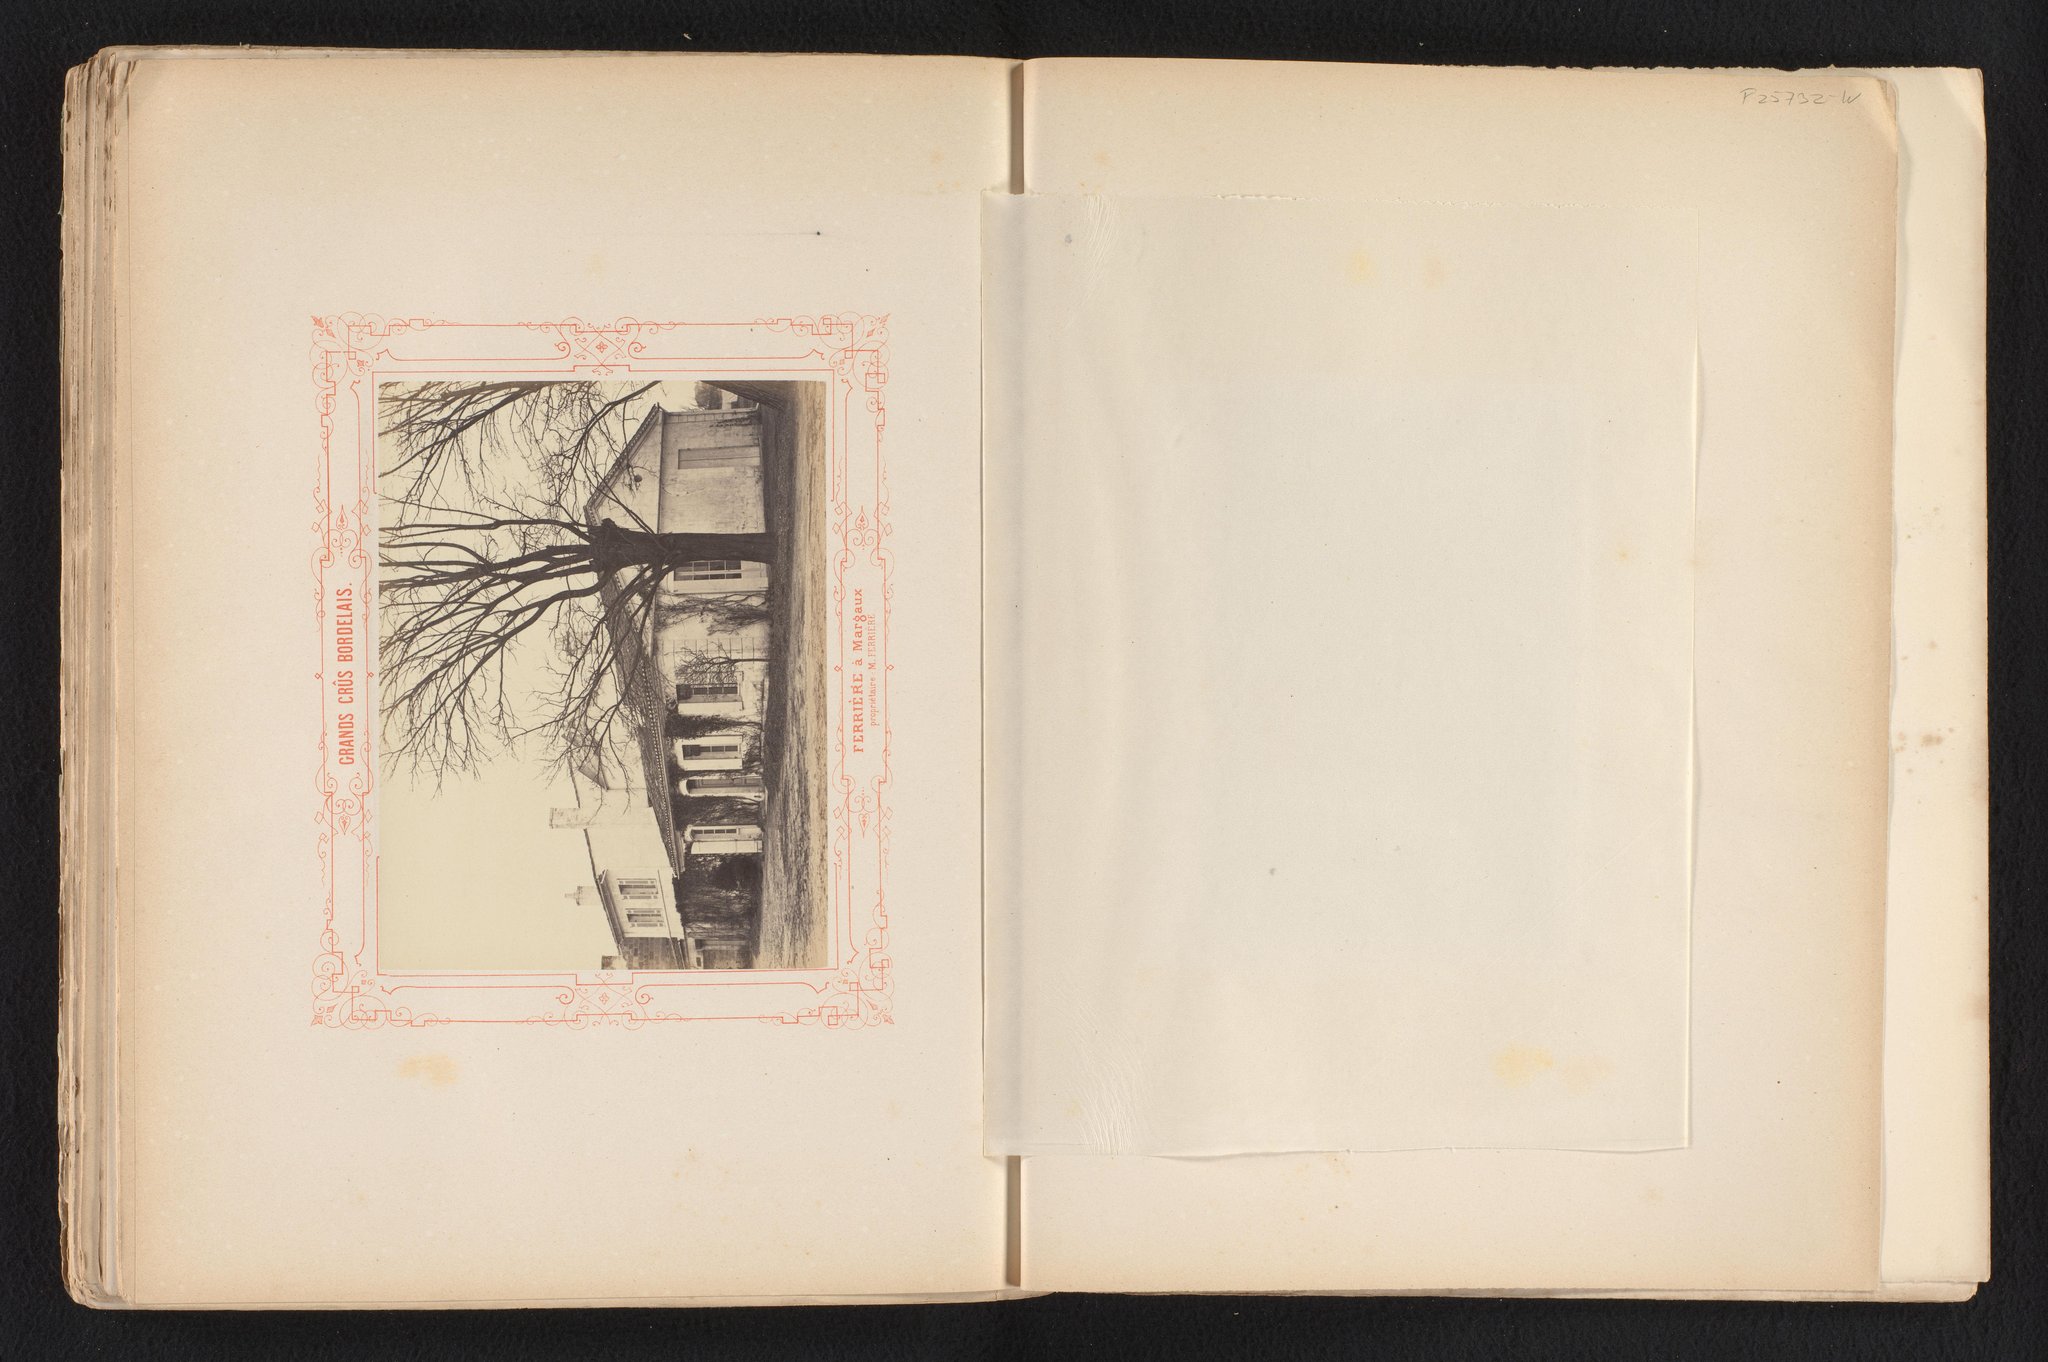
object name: page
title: Grands crûs Bordelais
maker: alfred danflou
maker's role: fotograaf, schrijver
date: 1862-1867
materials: paper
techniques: albumen print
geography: margaux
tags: castle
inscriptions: inscription: ‘propriétaire: M. FERRIÈRE.’